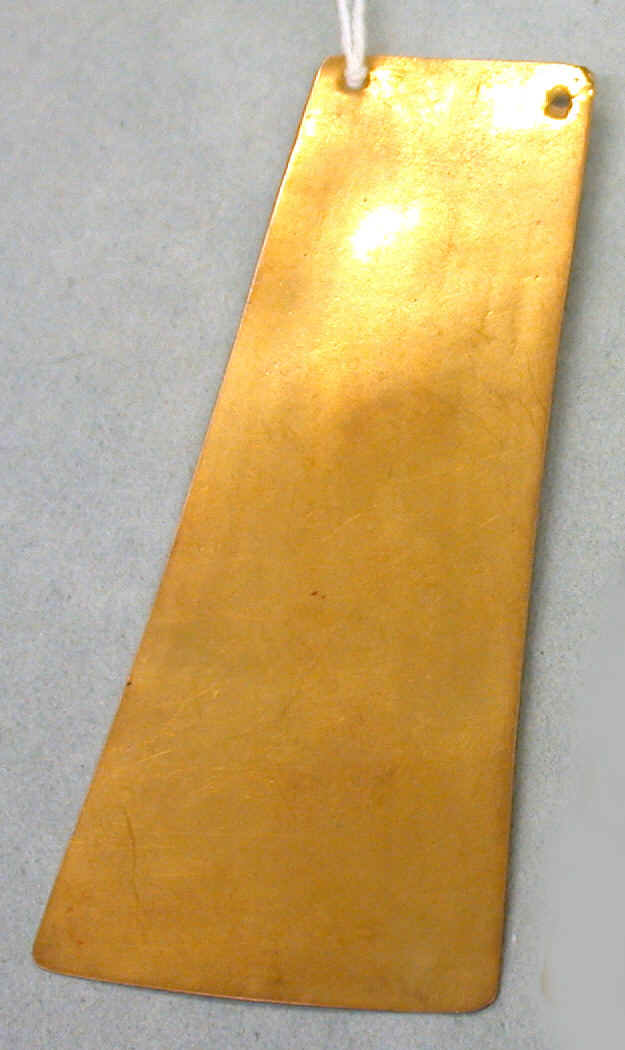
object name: ornament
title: Tab Ornament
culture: salinar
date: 100 BCE-200 CE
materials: gold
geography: peru